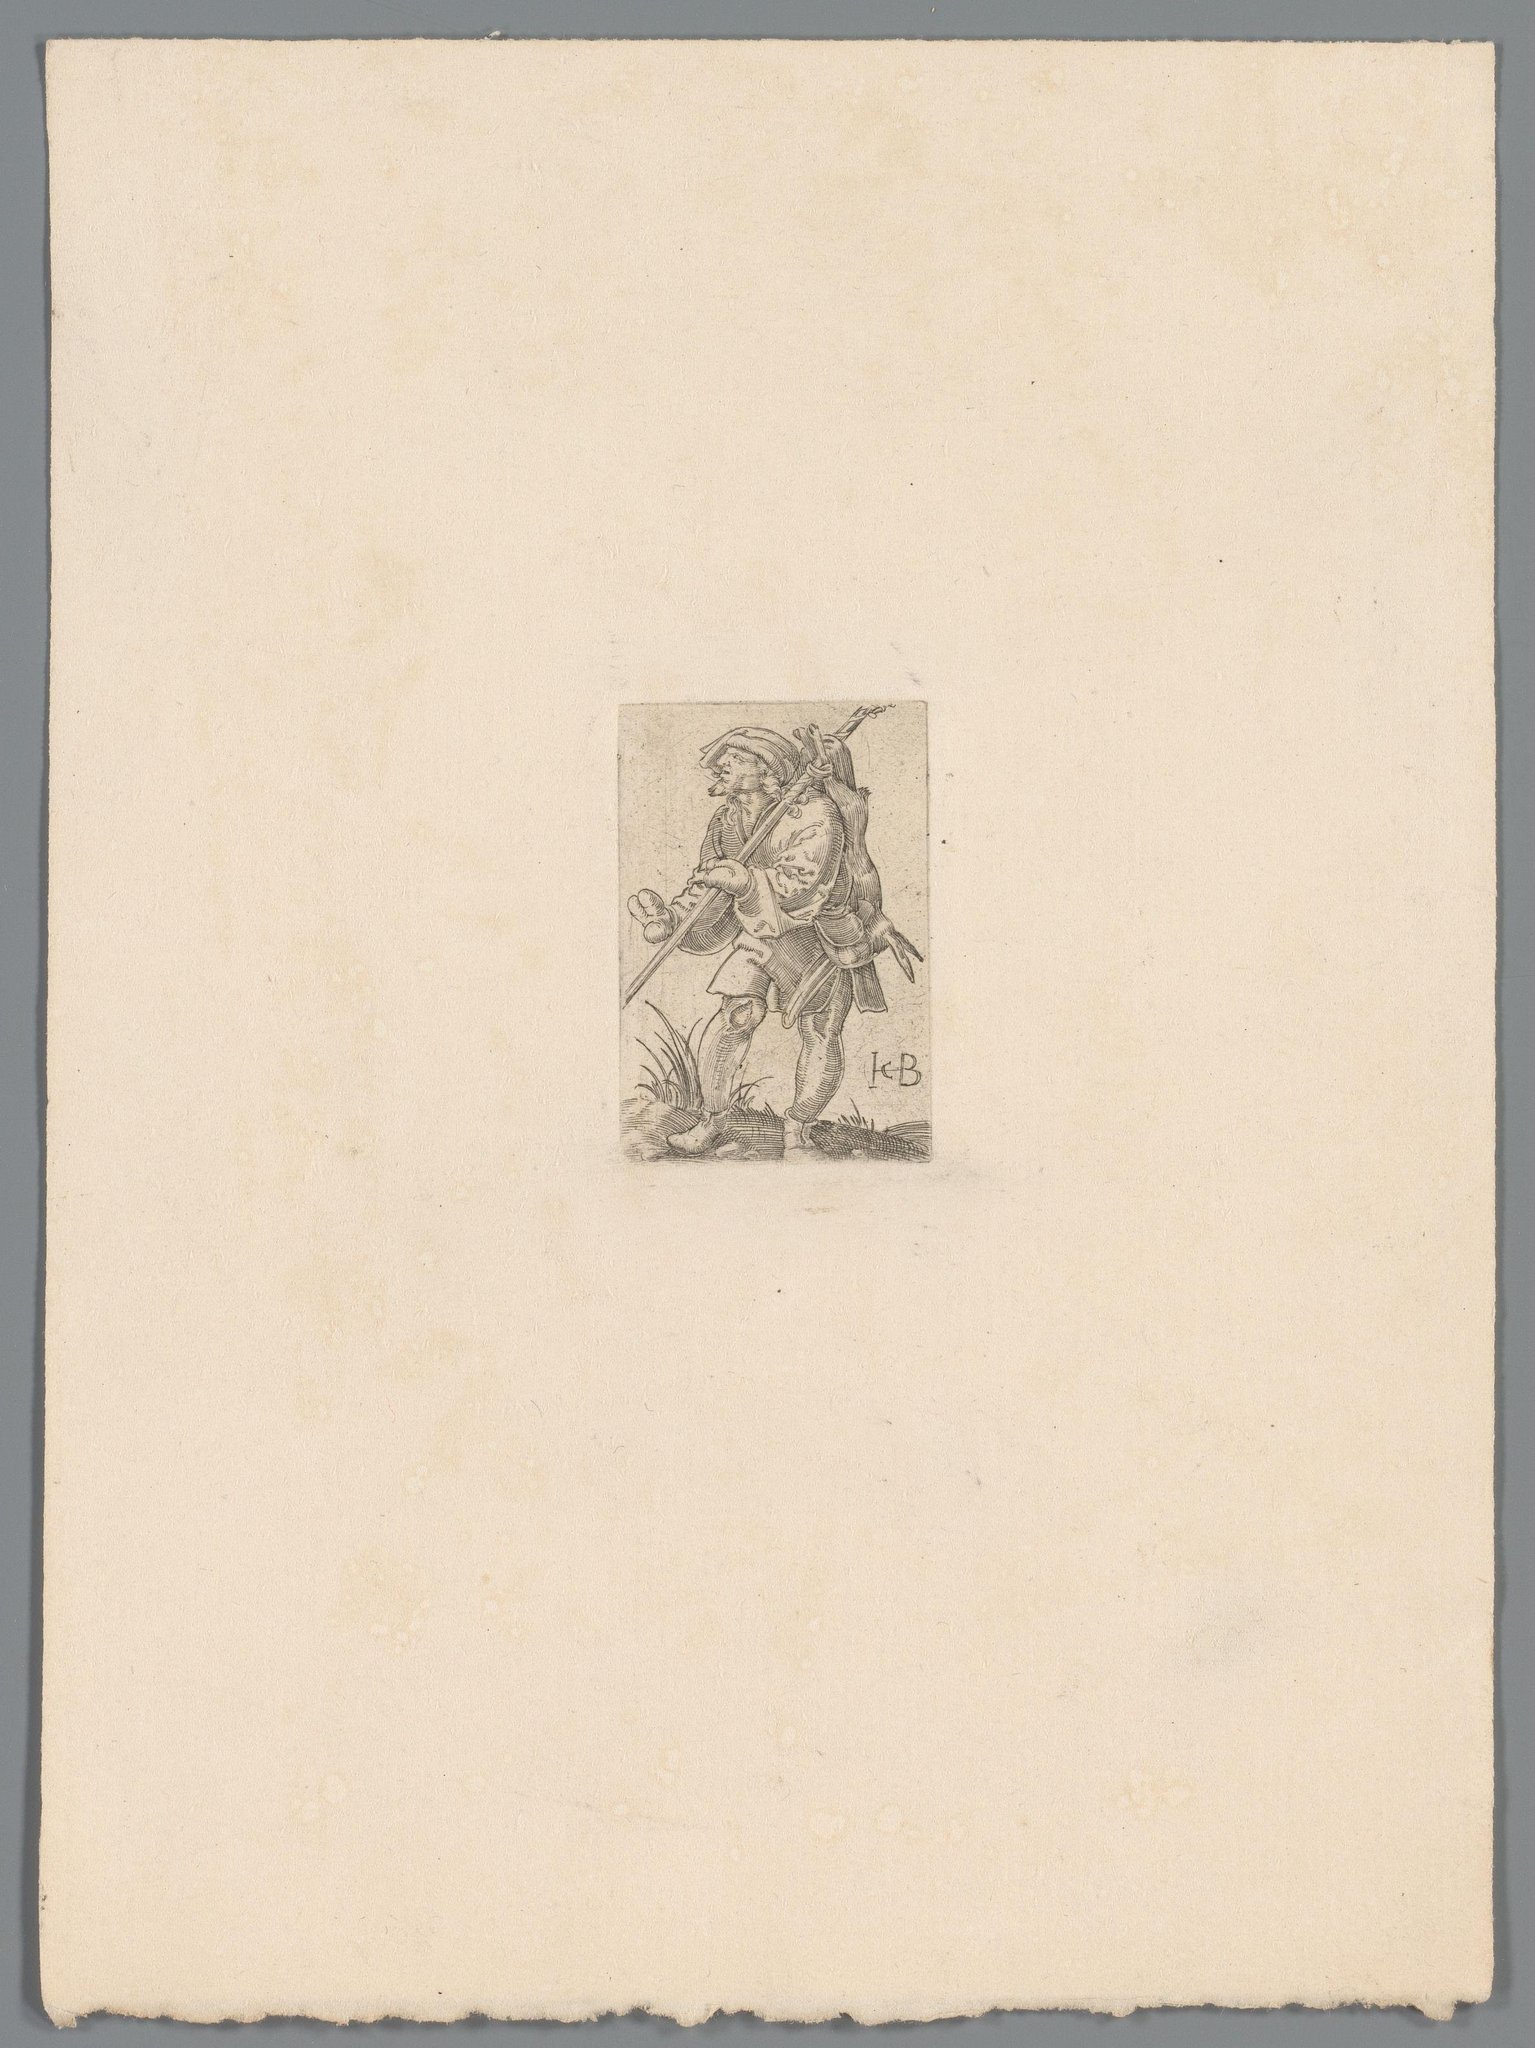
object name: print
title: Boer met gevangen haas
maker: jacob binck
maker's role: painter, print maker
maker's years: 1494-1569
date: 1510-1569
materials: paper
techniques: engraving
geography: germany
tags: rodents: hare, farmers